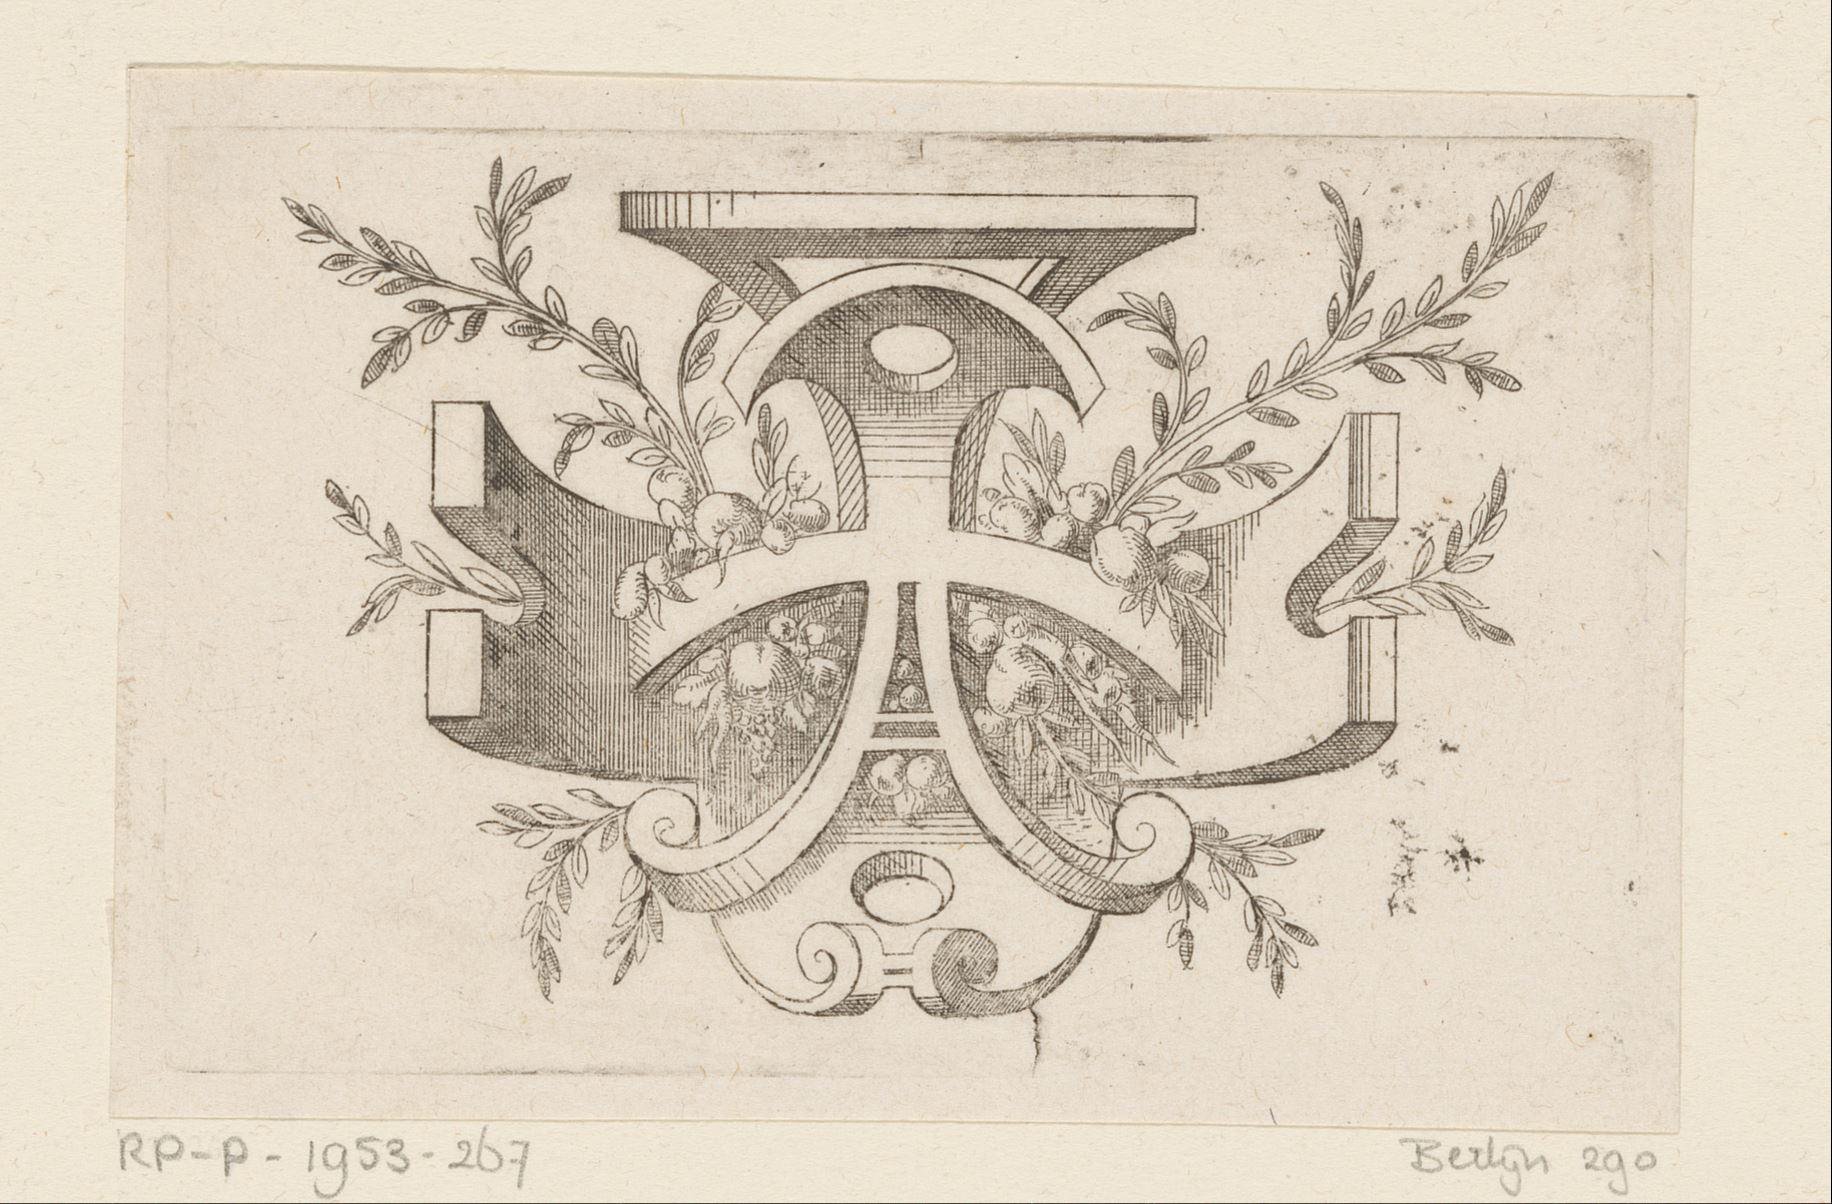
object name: ornament print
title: Rolwerk met fruit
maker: jacques androuet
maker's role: draughtsman, print maker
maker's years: 1515-1584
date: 1520-1584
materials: paper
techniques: etching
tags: fruits and vegetables ~ ornament, scrollwork, strapwork ~ ornament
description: Cartouche van rolwerk met vruchten en zes takken met bladeren, bijeengehouden door enkele voluten.